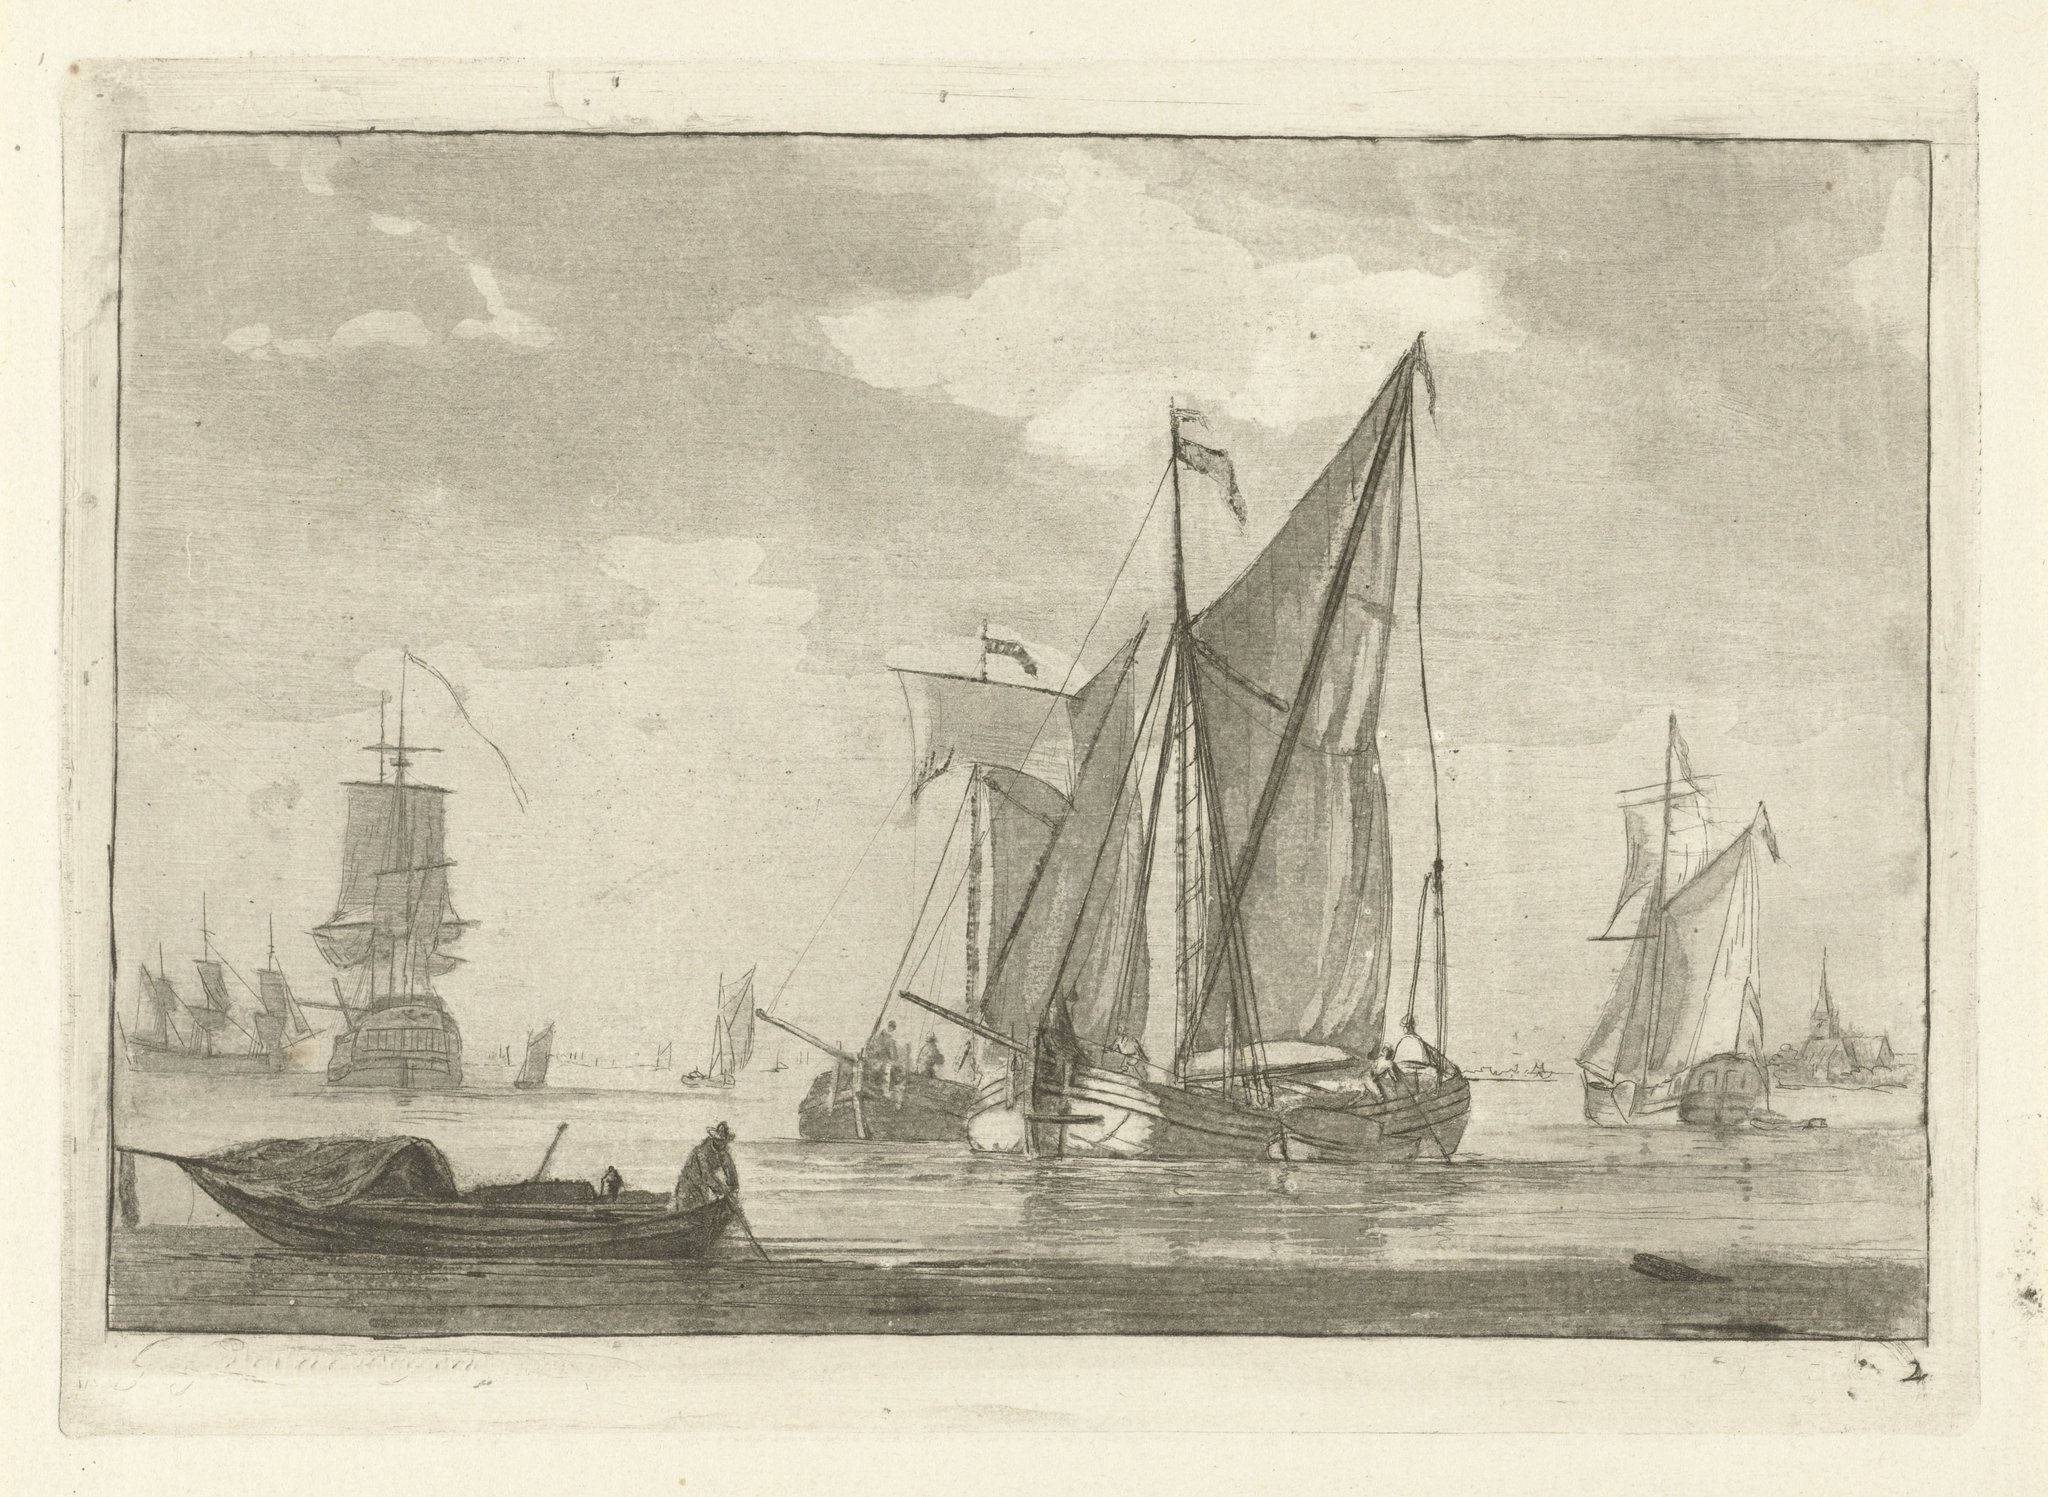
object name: print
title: Verschillende schepen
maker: gerrit groenewegen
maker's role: draughtsman, print maker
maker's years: 1754-1826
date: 1791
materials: paper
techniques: aquatint, etching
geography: rotterdam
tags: ships (in general) - cc - more than one ship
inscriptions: collector's mark: Lugt 2228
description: Vijf grote zeilschepen, met op de voorgrond een roeiboot met daarin een figuur. Rechts op de achtergrond een kerk. Deze prent maakt deel uit van een serie van zes prenten met verschillende schepen.